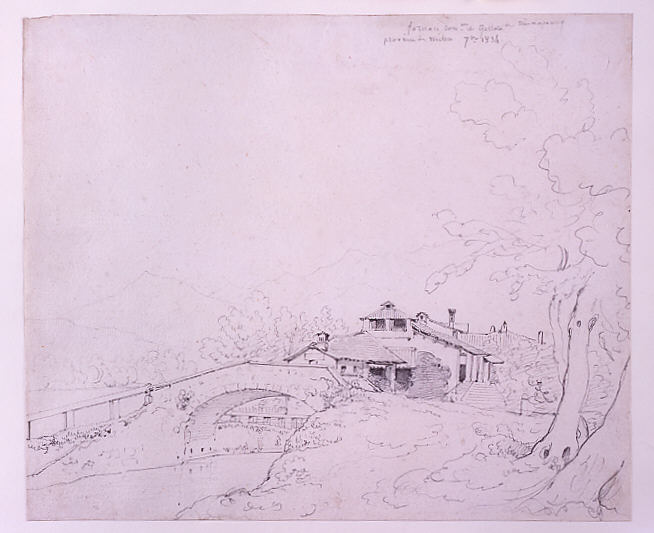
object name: drawing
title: Gessate in the Province of Milan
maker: jean-baptiste-camille corot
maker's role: artist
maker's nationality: french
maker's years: 1796-1875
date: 1834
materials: pencil, paper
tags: bridges,landscapes